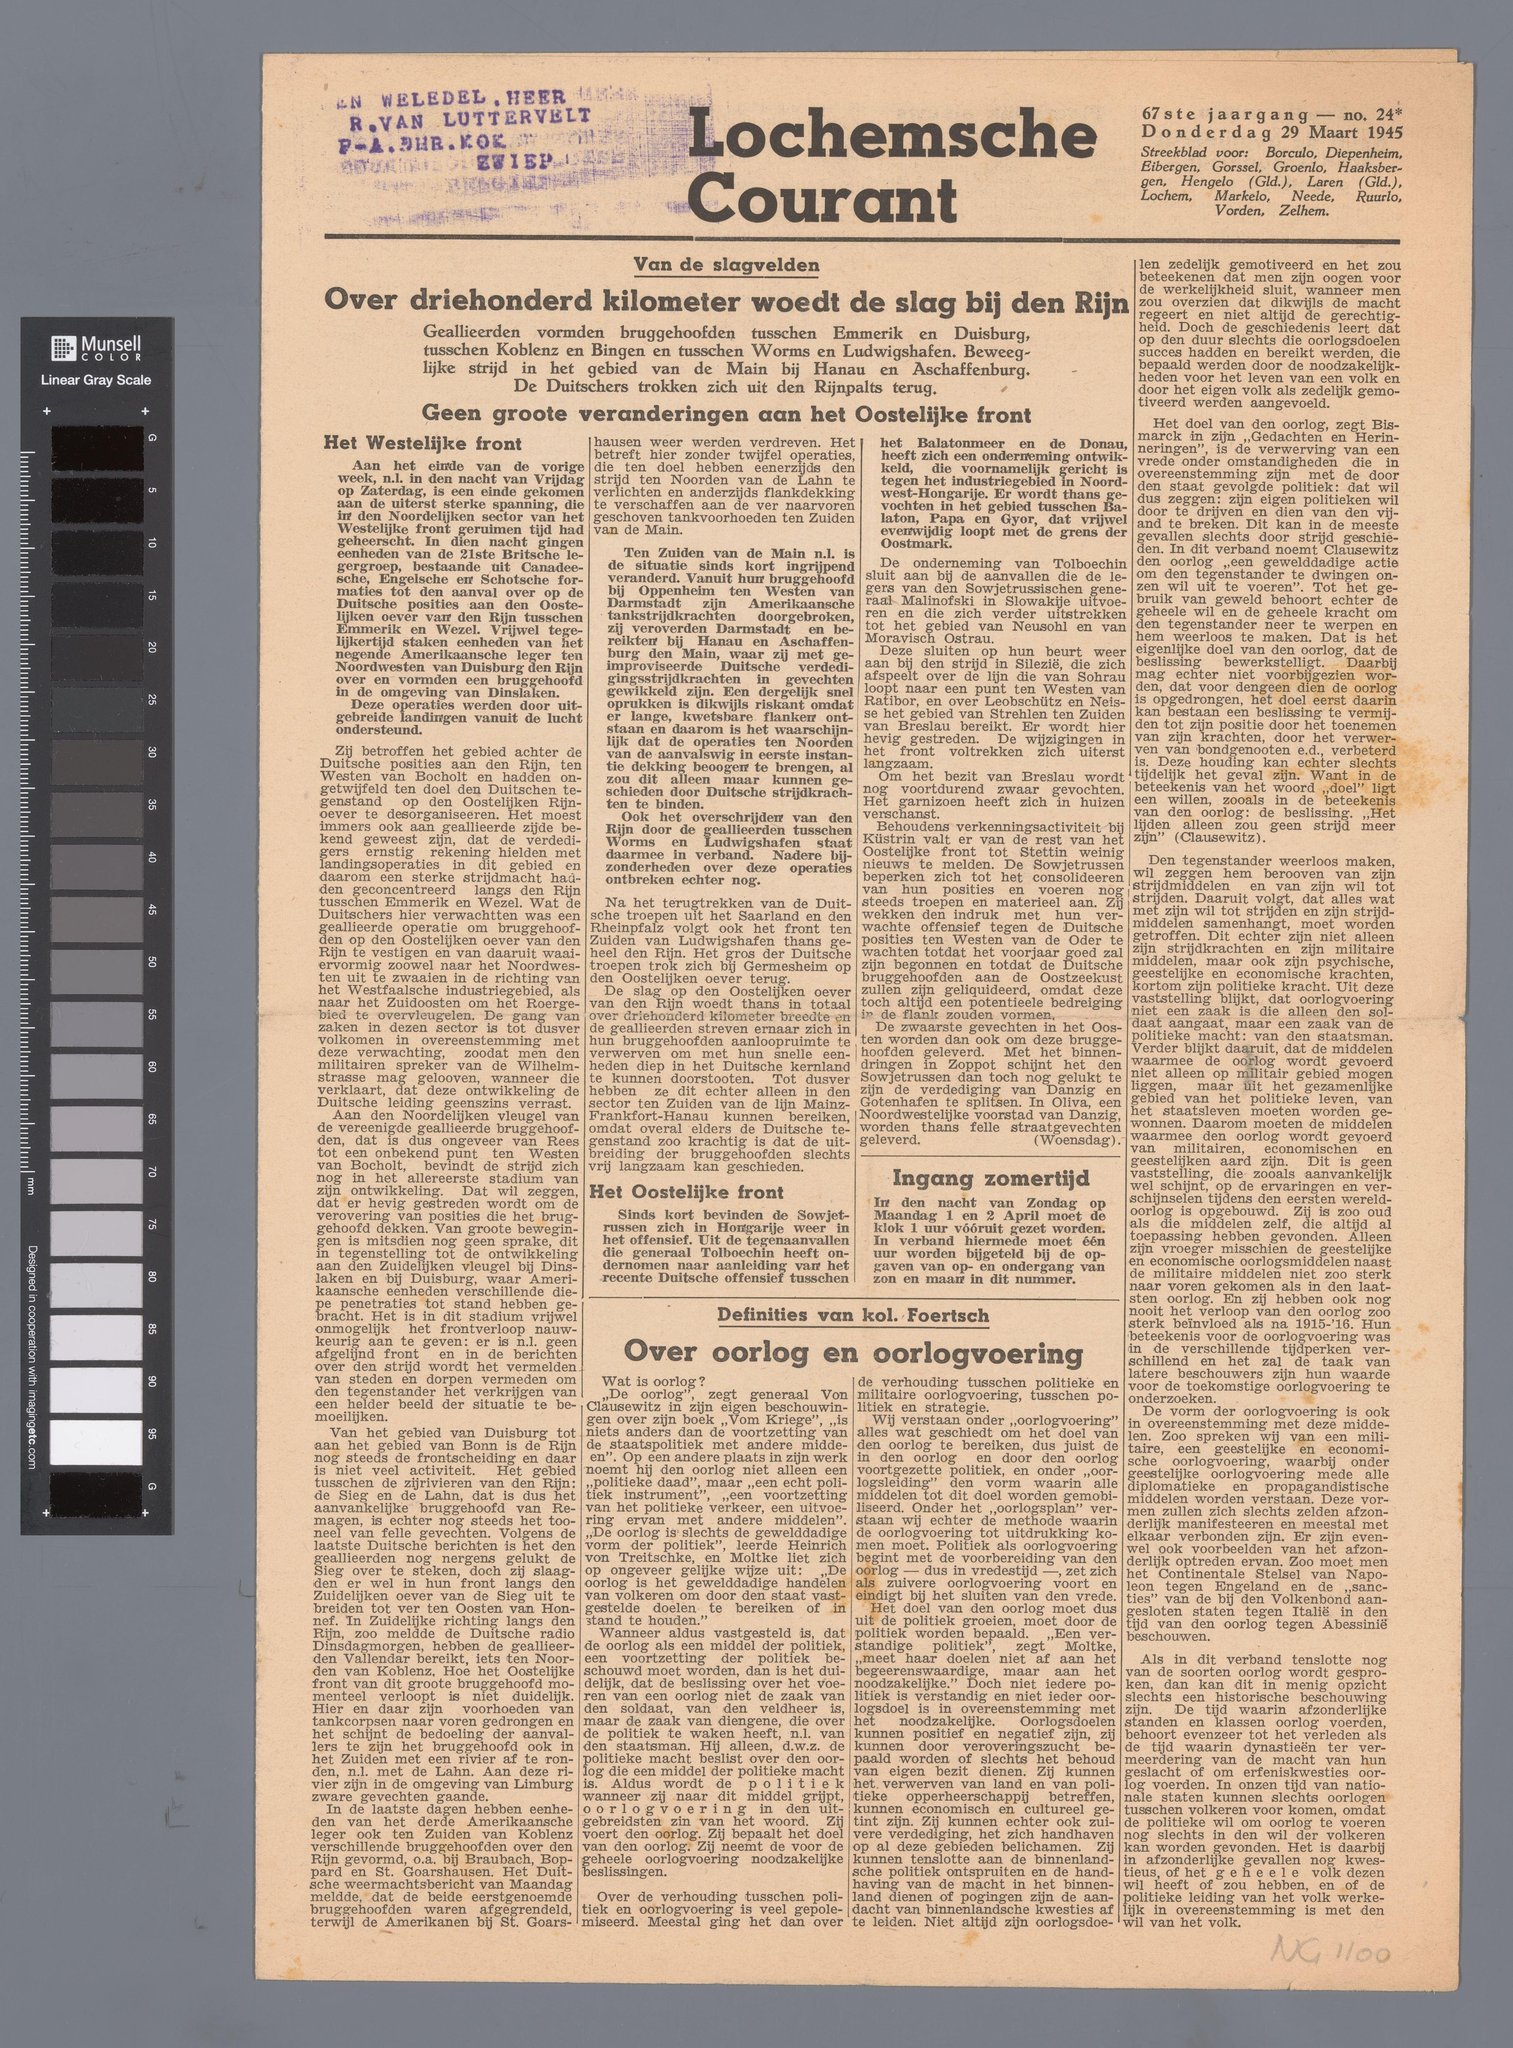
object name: newspaper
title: Lochemse Courant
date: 1945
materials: ink, paper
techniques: printing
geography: lochem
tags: netherlands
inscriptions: inscription: ‘LOCHEMSE COURANT / Van de slagvelden / Over driehonderd kilometer woedt de slag bij den Rijn’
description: Krant van 4 pagina's over de slag bij de Rijn, de geallieerde vredesorganisatie en bevattende artikelen over oorlog en oorlogvoering, de oorsprong van het woord 'paard', twee verhalen en plaatselijk nieuws.